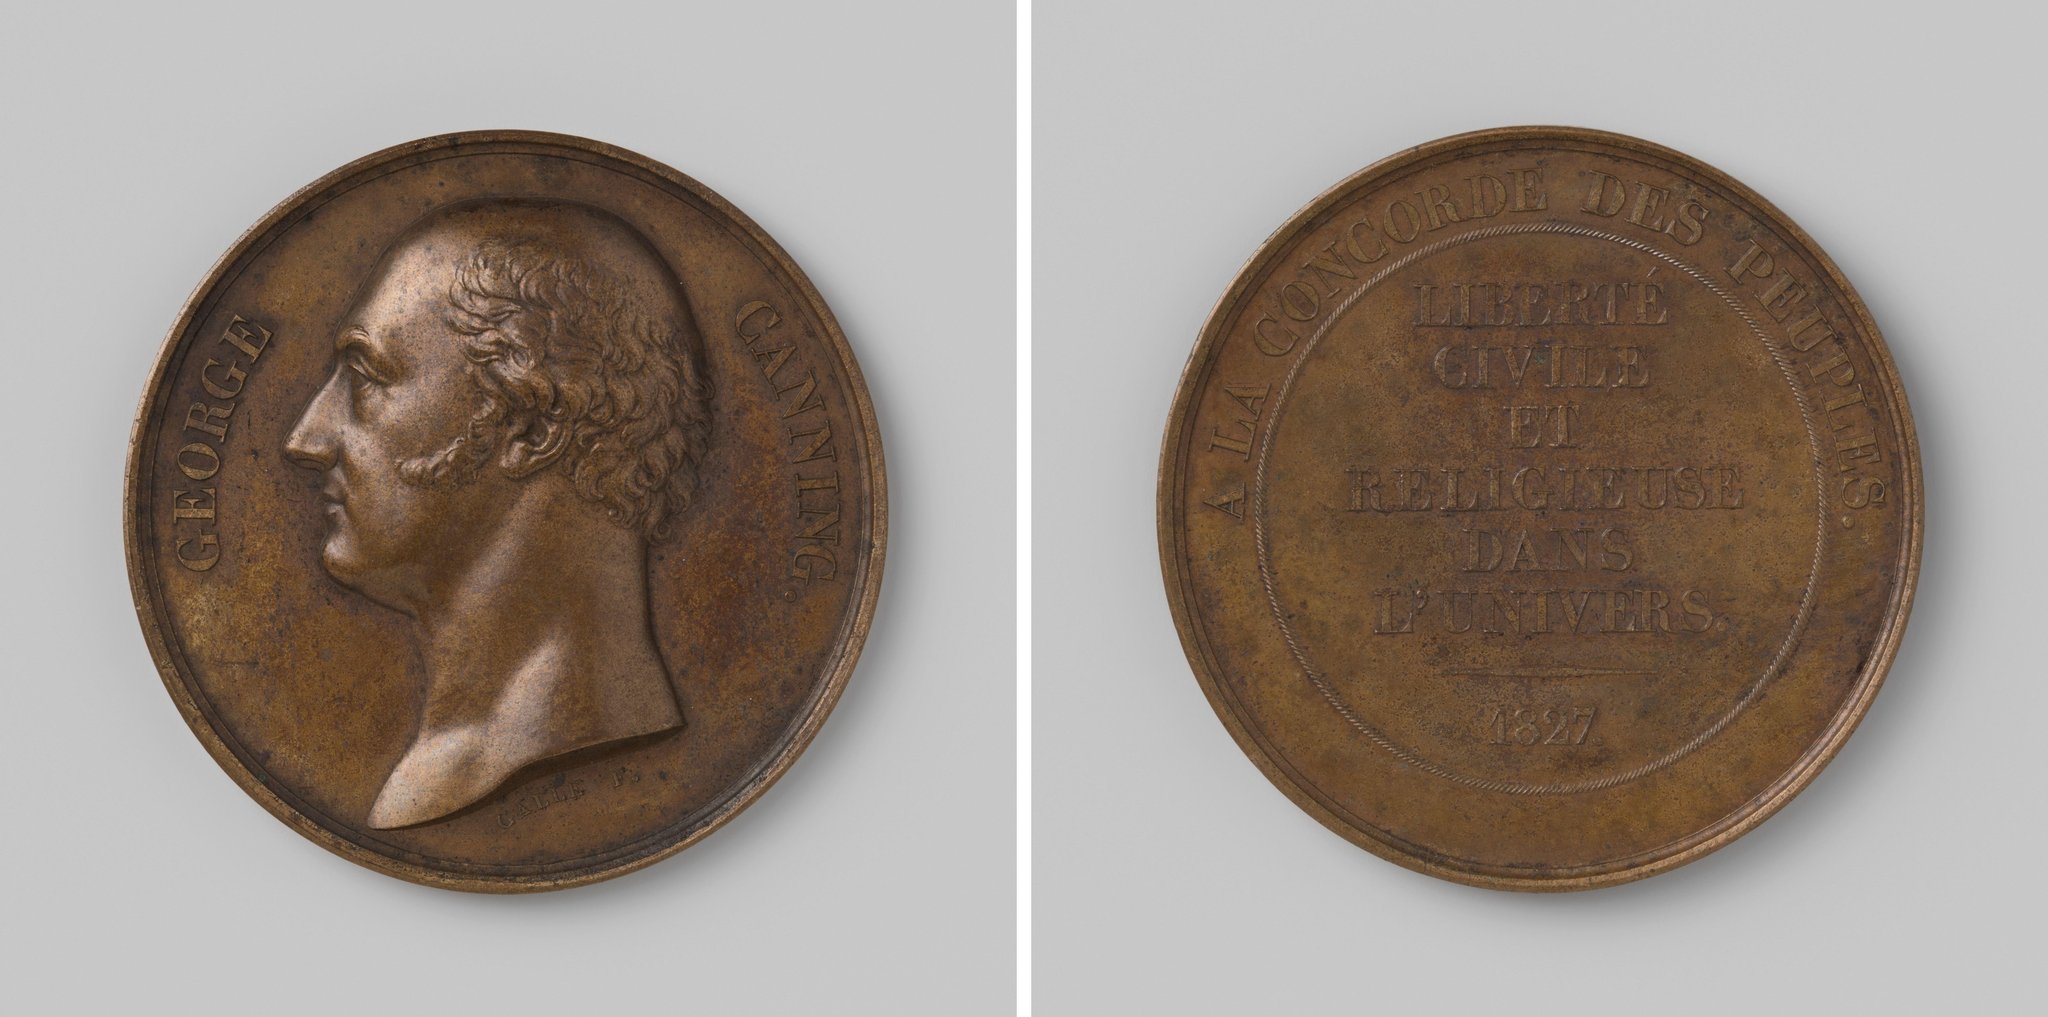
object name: history medal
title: George Canning, Engels staatsman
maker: andre galle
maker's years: 1761-1844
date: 1827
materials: bronze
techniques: striking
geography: paris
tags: minister van financiën, minister van buitenlandse zaken, minister president, george canning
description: Bronzen penning. Voorzijde: borststuk man binnen omschrift. Keerzijde: opschrift binnen omschrift.